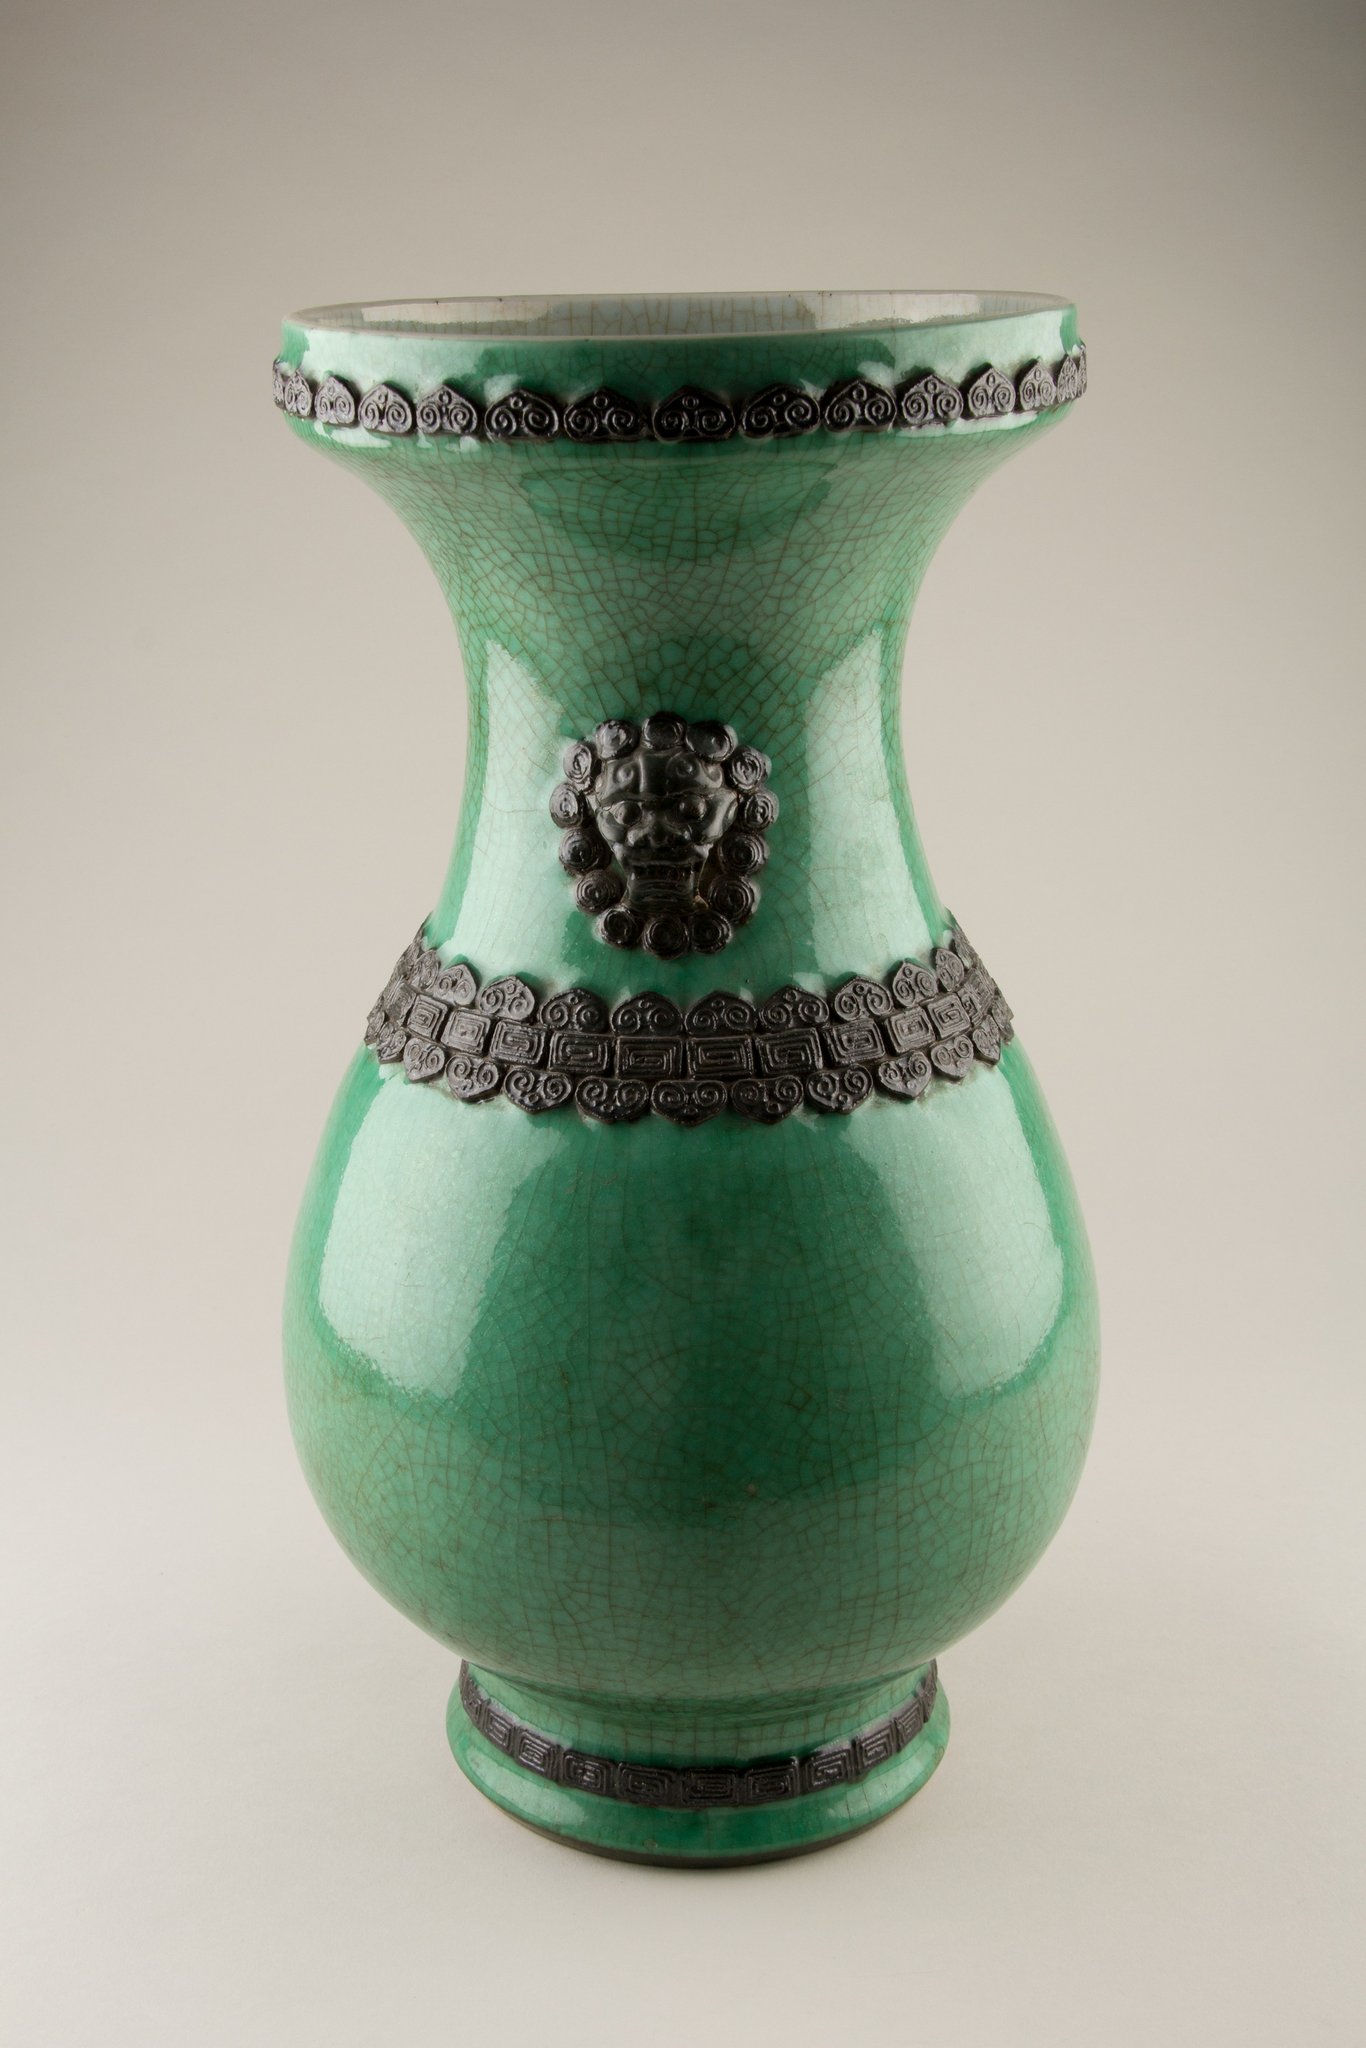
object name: vase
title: Vase with lion-head handles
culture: chinese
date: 1701-1800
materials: glaze, porcelain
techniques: relief